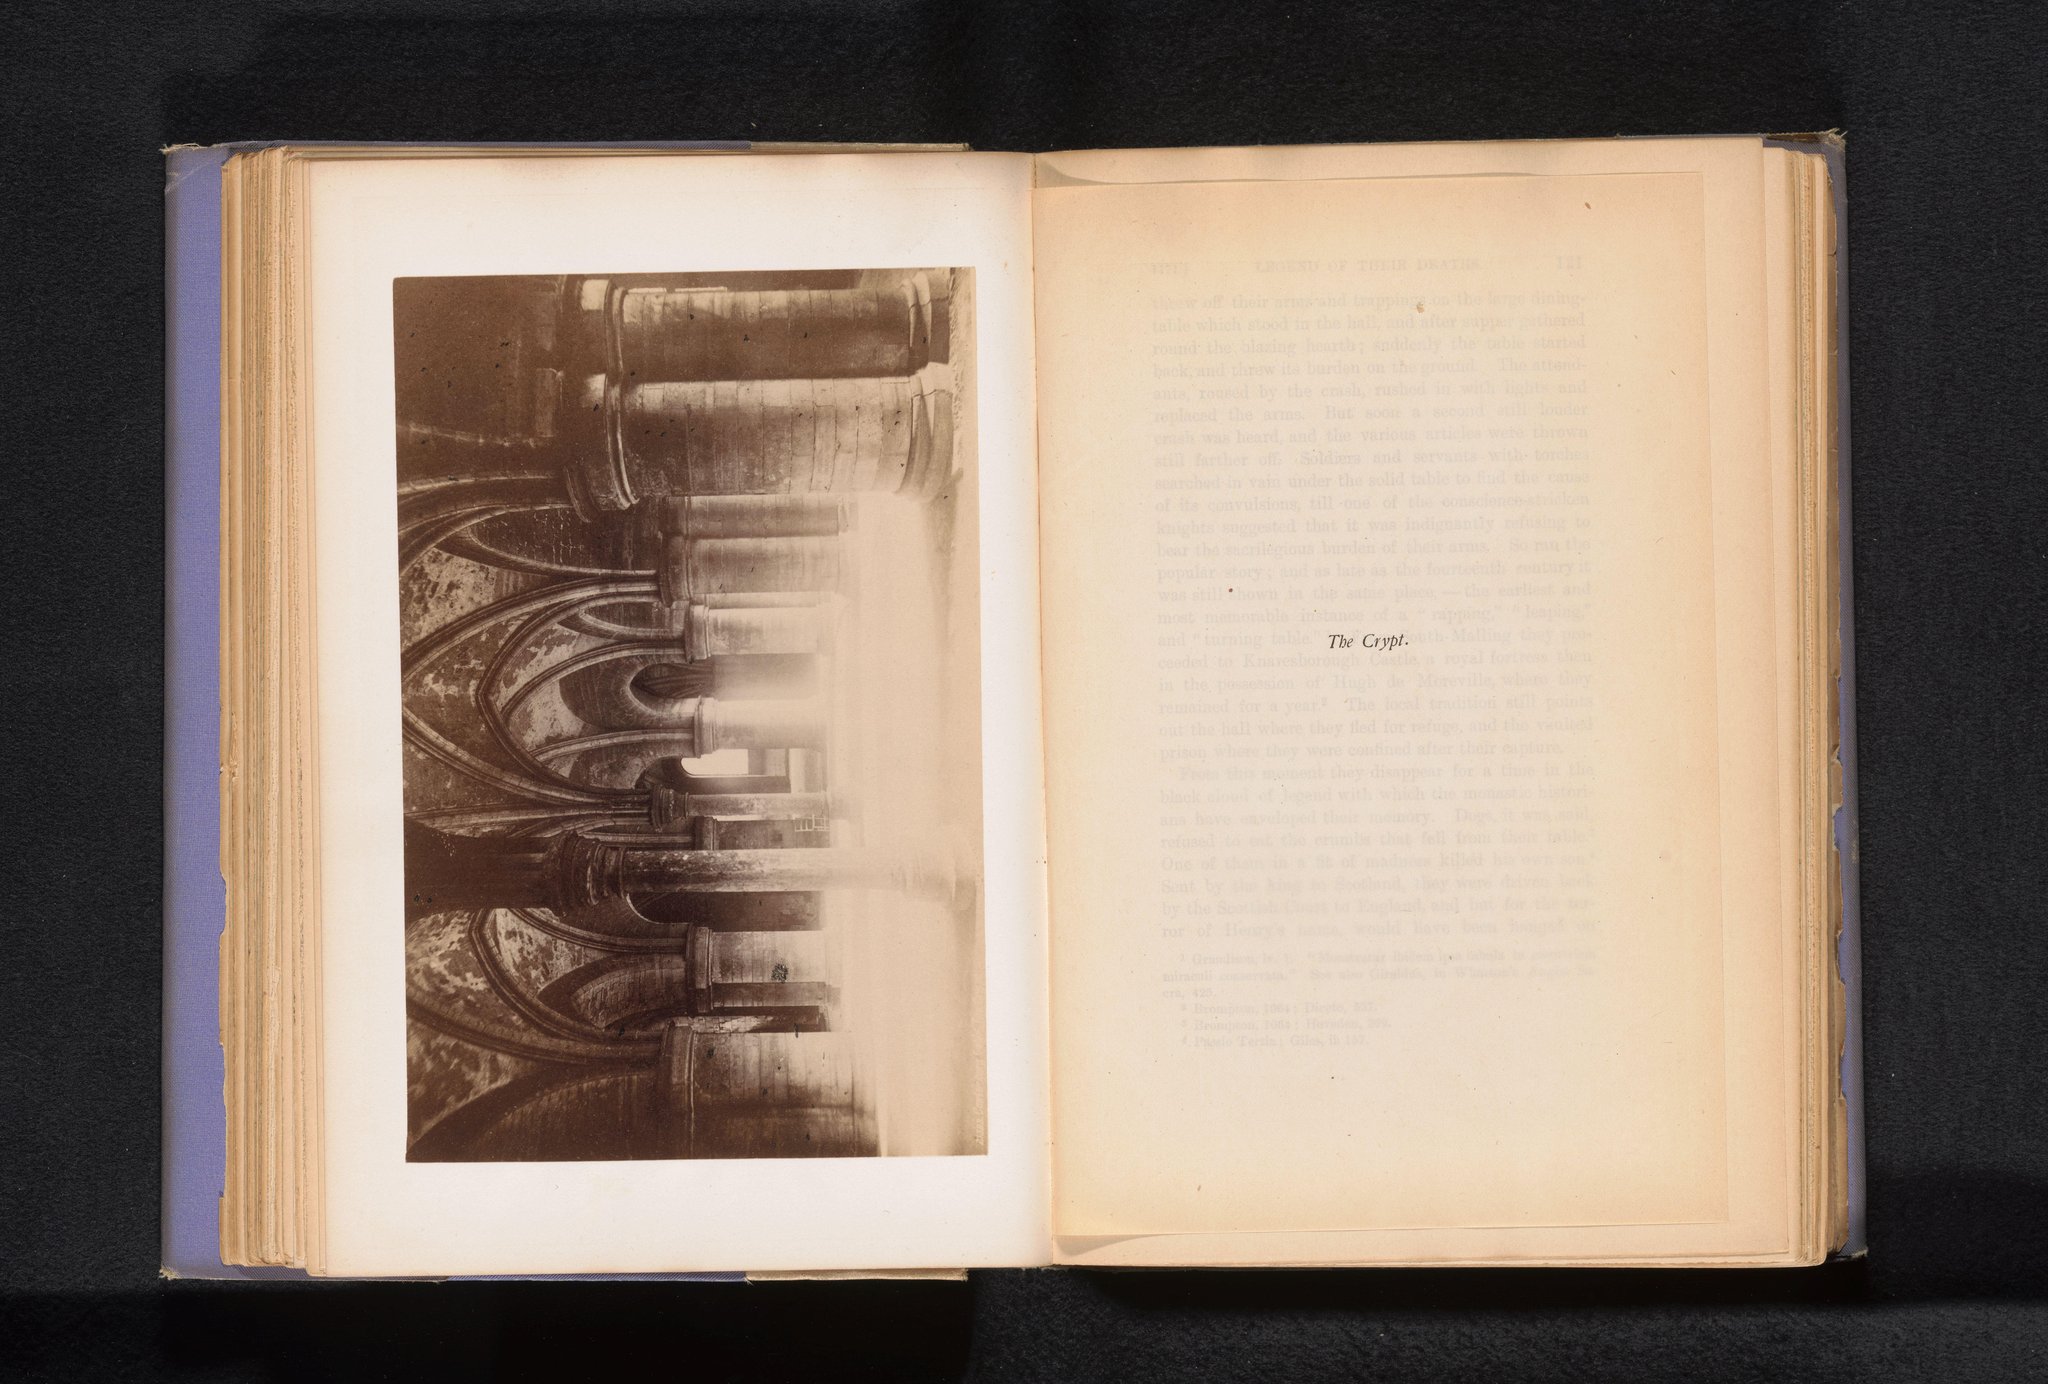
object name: page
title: The Crypt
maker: Anonymous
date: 1882-1892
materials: photographic support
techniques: albumen print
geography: canterbury cathedral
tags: parts of church interior (crypt)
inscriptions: number: ‘21332 [...]’